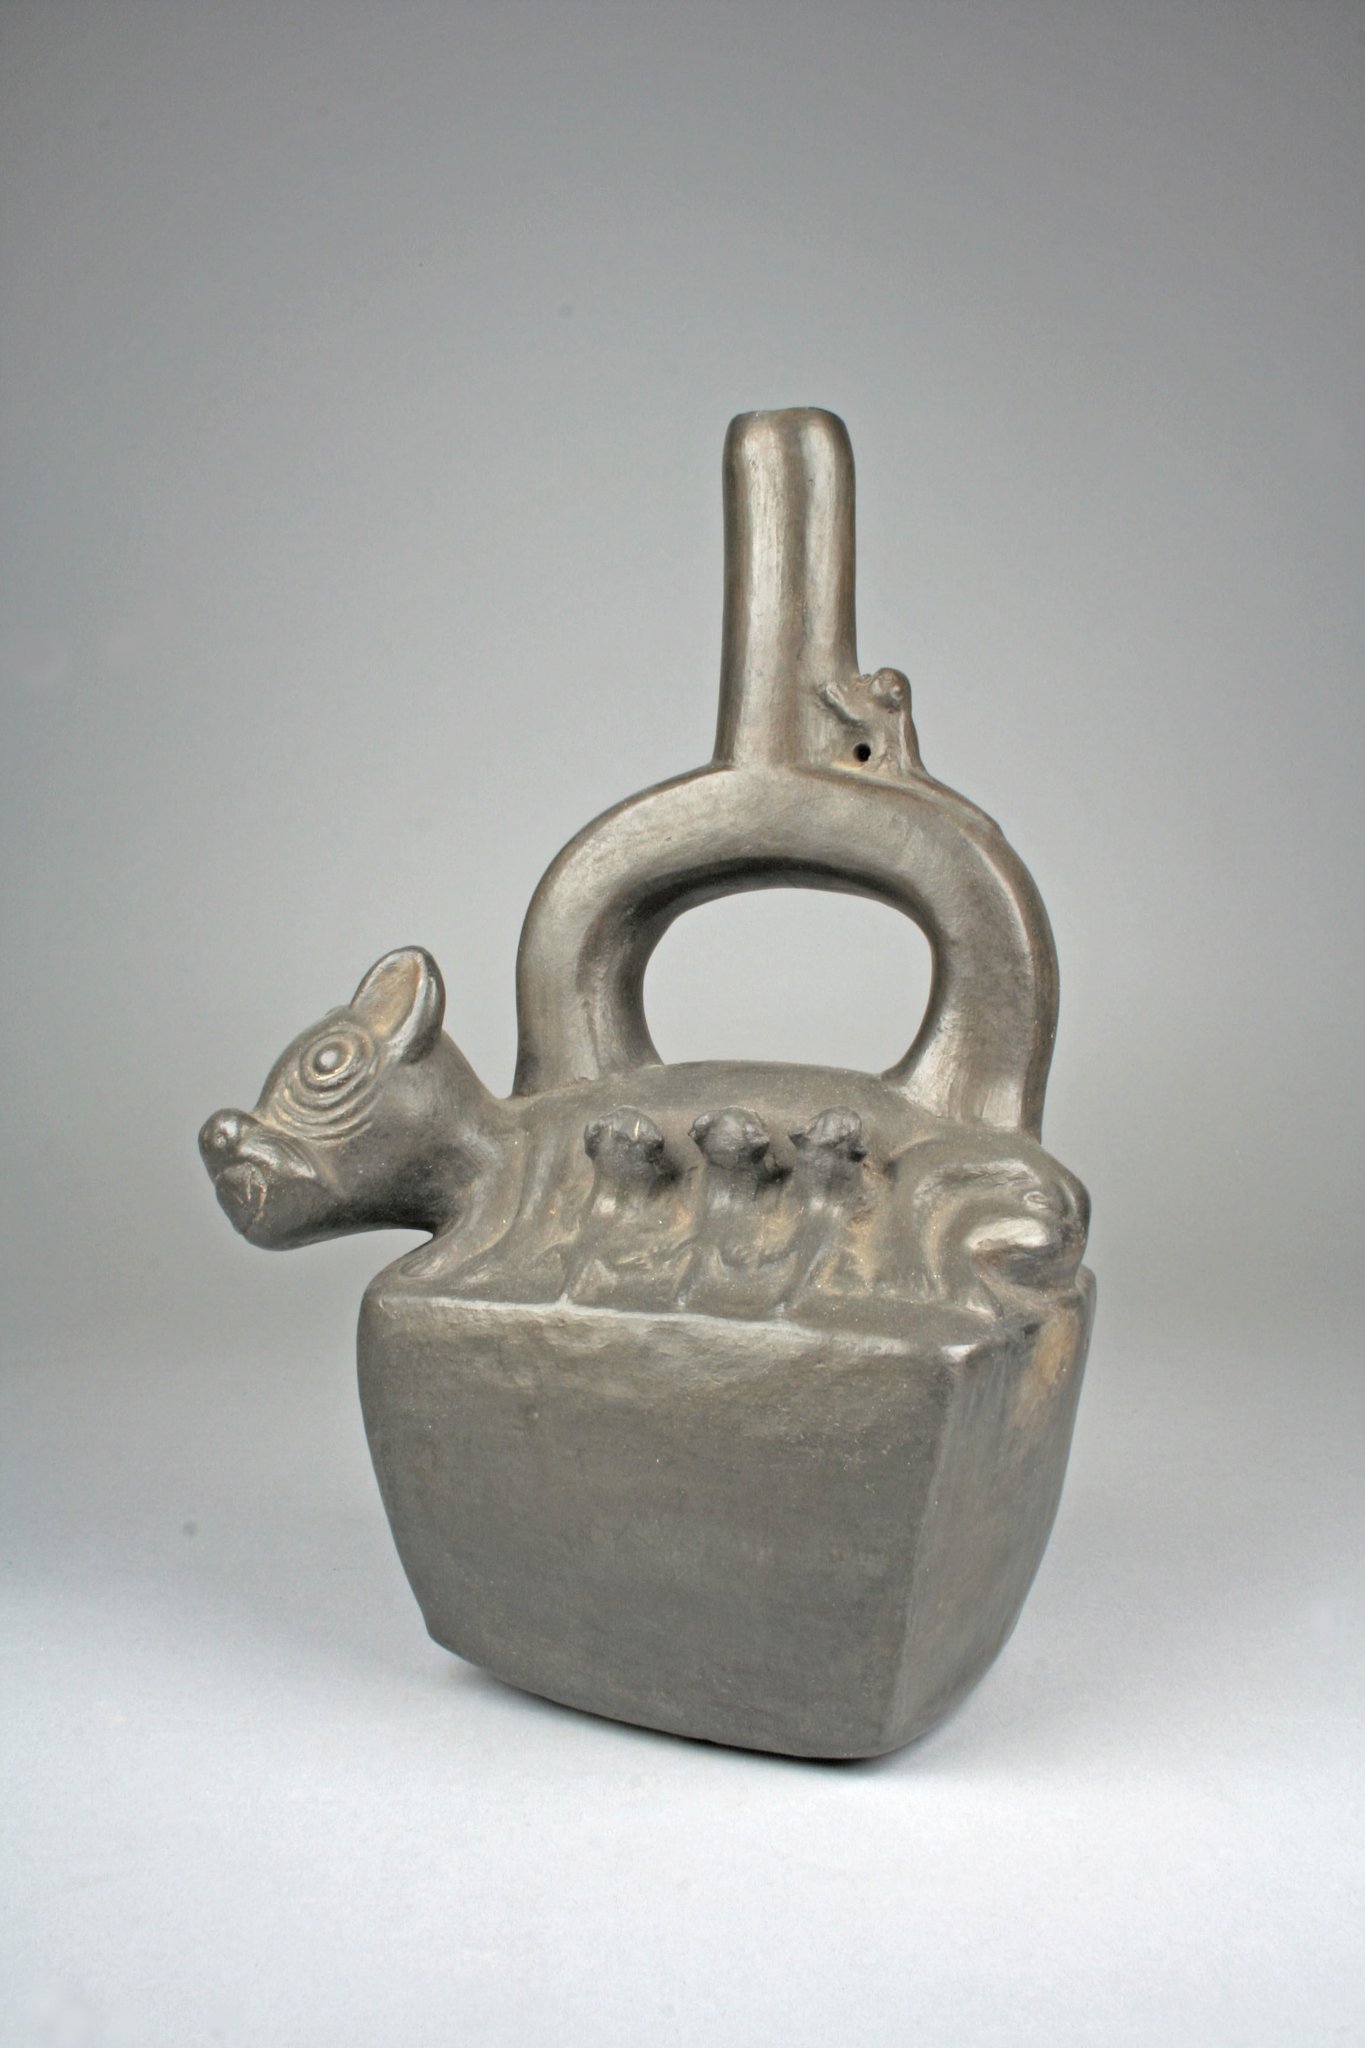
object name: bottle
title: Stirrup Spout Bottle with Animals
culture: chimú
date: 1301-1500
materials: ceramic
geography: peru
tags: animals